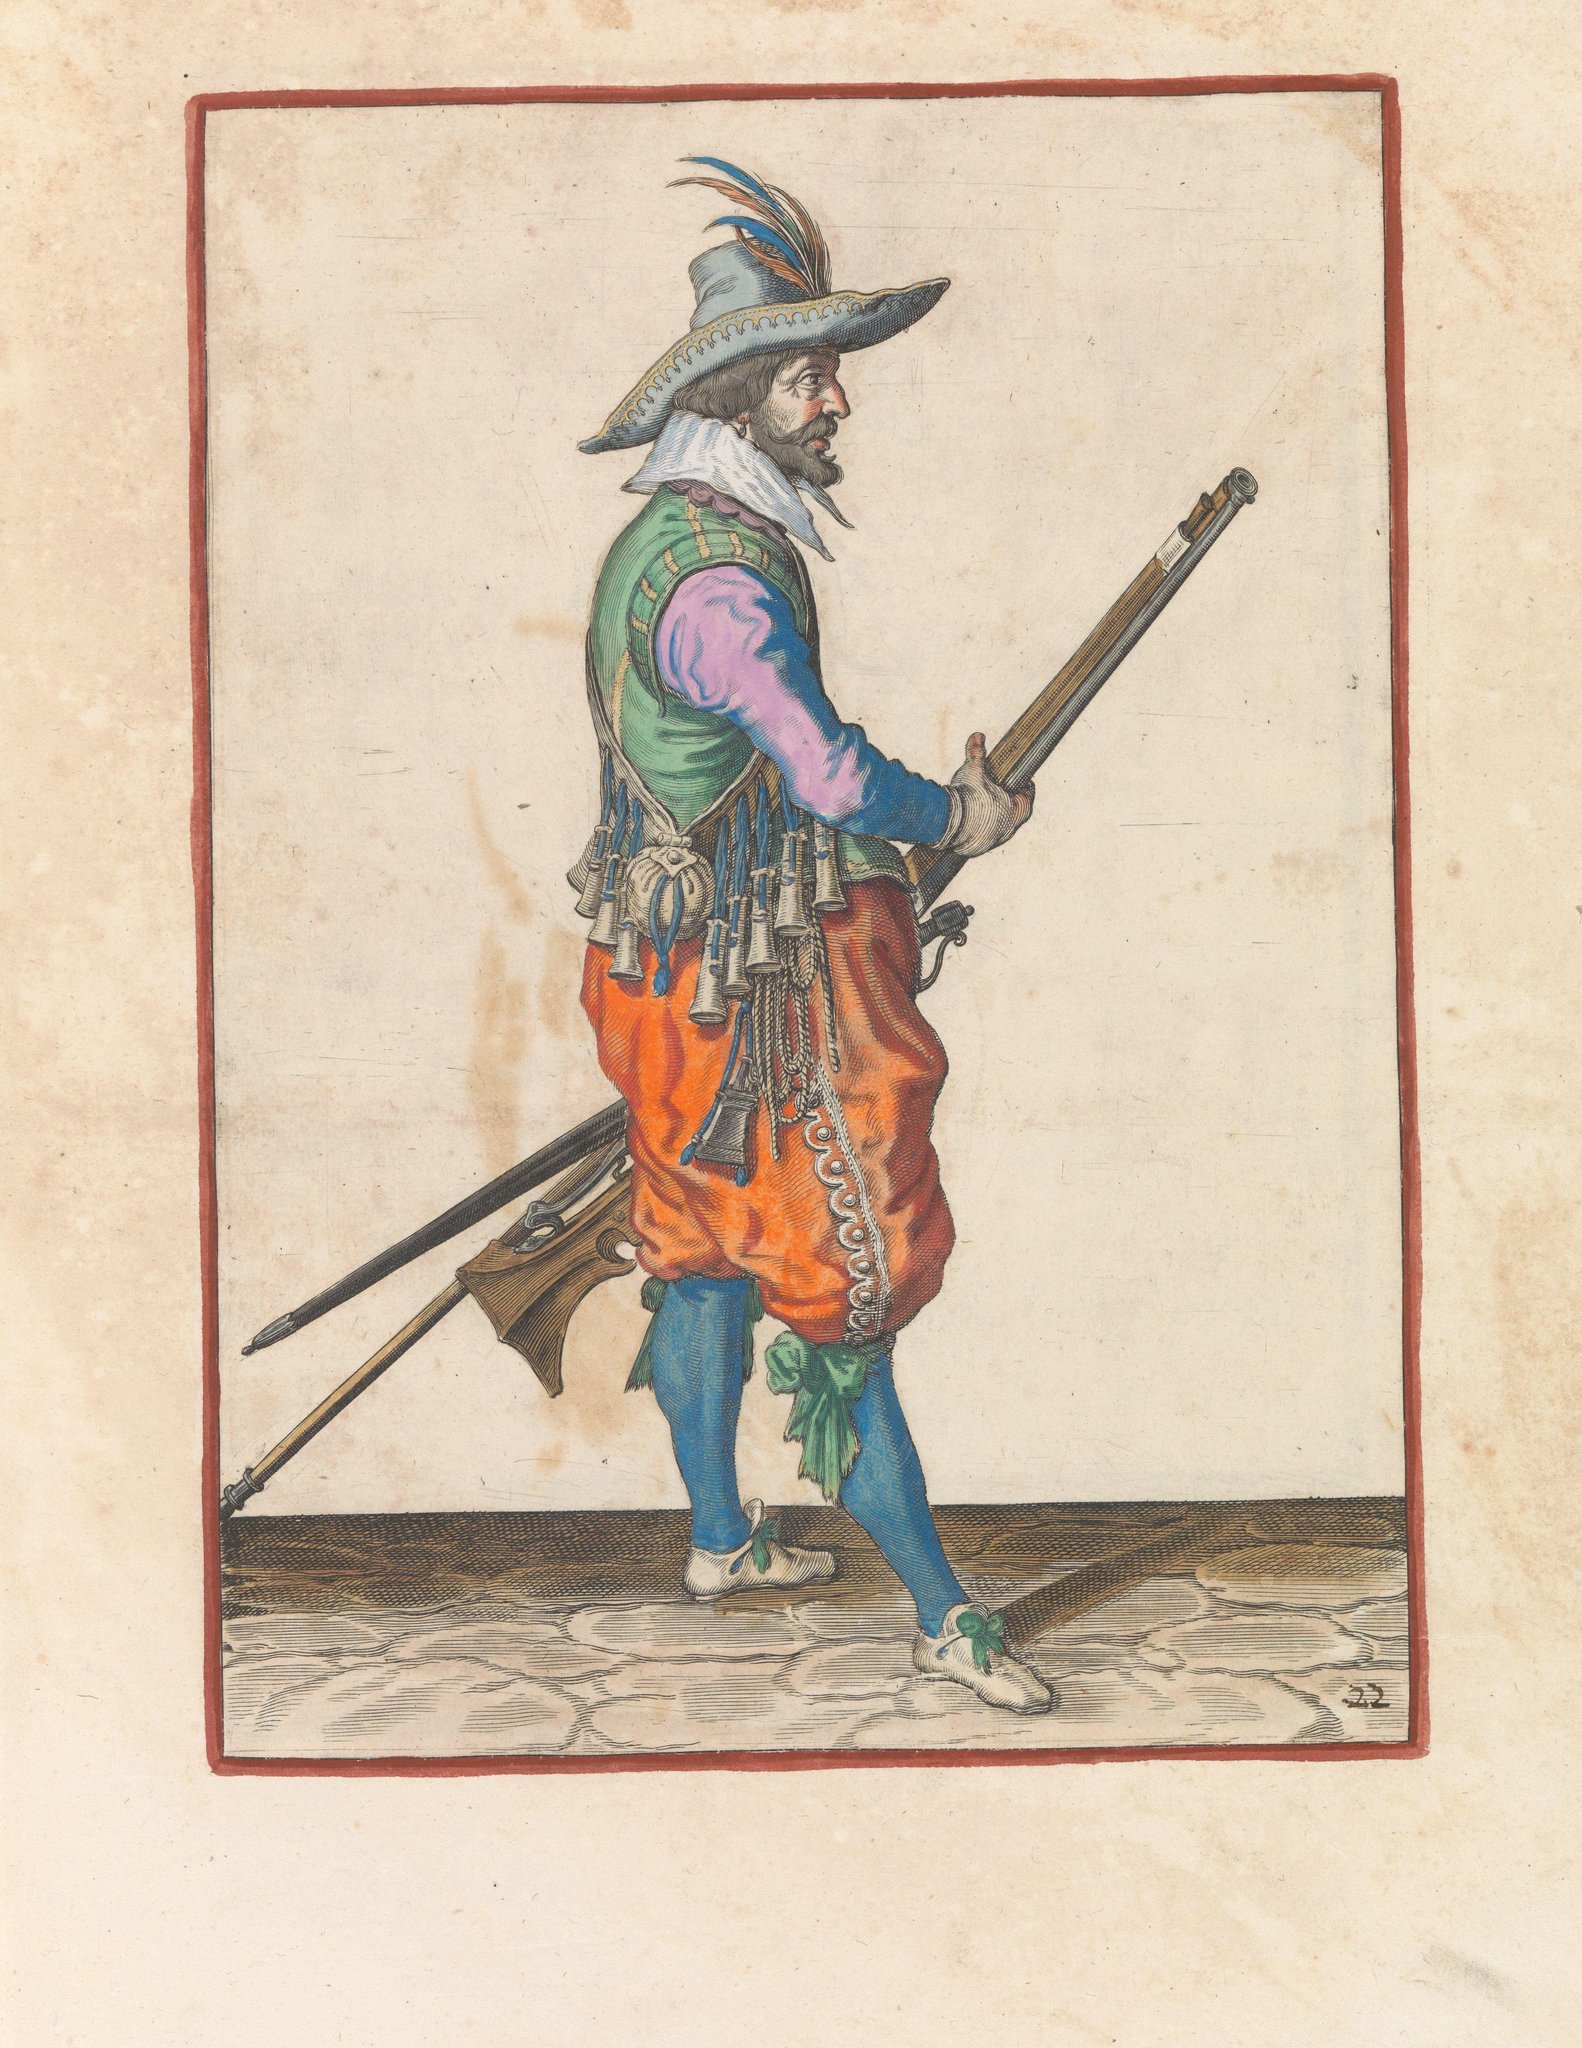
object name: print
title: Corte onderrechtinghe op de figuerliicke afbeeldinghe, soo veel aengaet het recht ghebruyck vant Musquet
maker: jacques de gheyn (ii)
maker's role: painter, print maker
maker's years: 1565-1629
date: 1597-1607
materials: paper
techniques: engraving, hand coloring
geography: the hague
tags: handling of weapons ~ military training, firearms: rifle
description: Een soldaat, ten voeten uit, naar rechts, die met beide handen bij zijn linkerdijbeen een musket (een bepaald type vuurwapen) vasthoudt. In zijn linkerhand behalve het musket ook een furket (musketvork). Deze prent is onderdeel van de reeks van 43 met de hand genummerde prenten van musketiers in de Wapenhandelinghe.